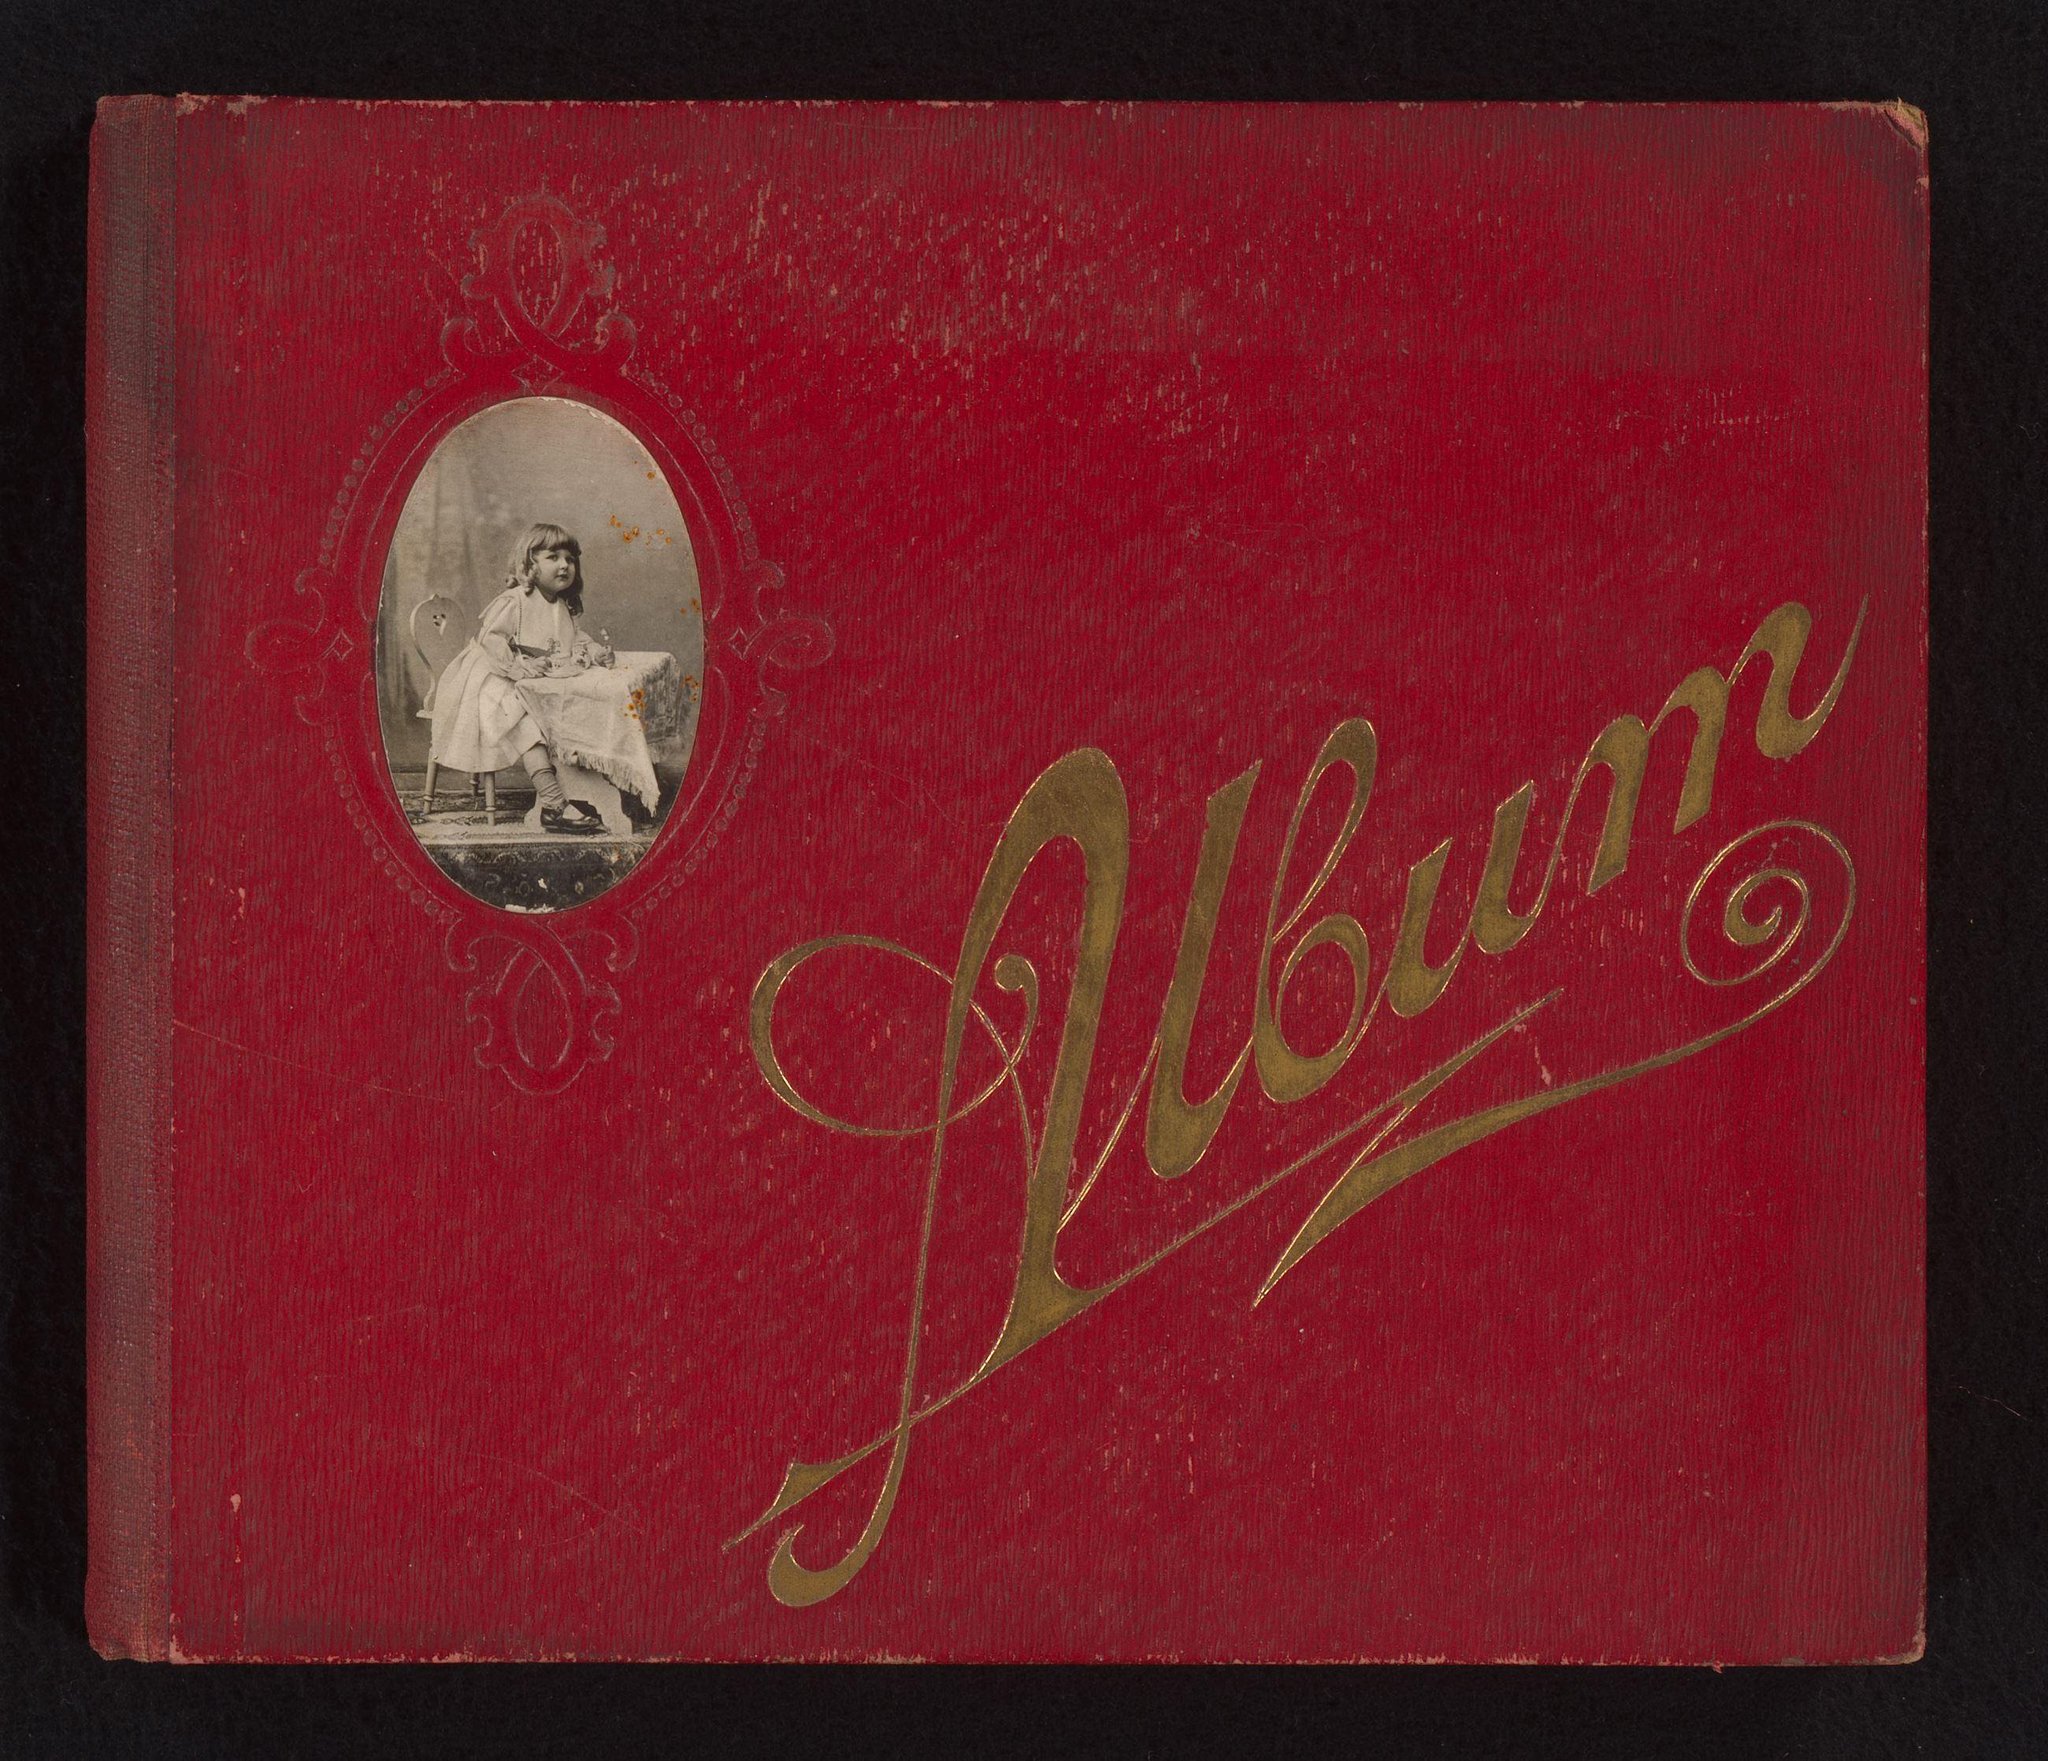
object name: photograph album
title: Album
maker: Anonymous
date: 1880-1920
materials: cardboard, paper, photographic support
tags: head-gear, child, trade games, imitative games, imitating adults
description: Verzamelalbum met 12 pagina's welke elk zes passe-partouts gevuld met foto's of fotomechanische afdrukken bevatten, in totaal 73 opnamen. Het album bevat portretten van voornamelijk kinderen en een enkele keer een jonge vrouw. De foto's of fotomechanische afdrukken konden bij verschillende producten of winkels verzameld worden. Op het voorplat is een foto van een meisje geplakt.